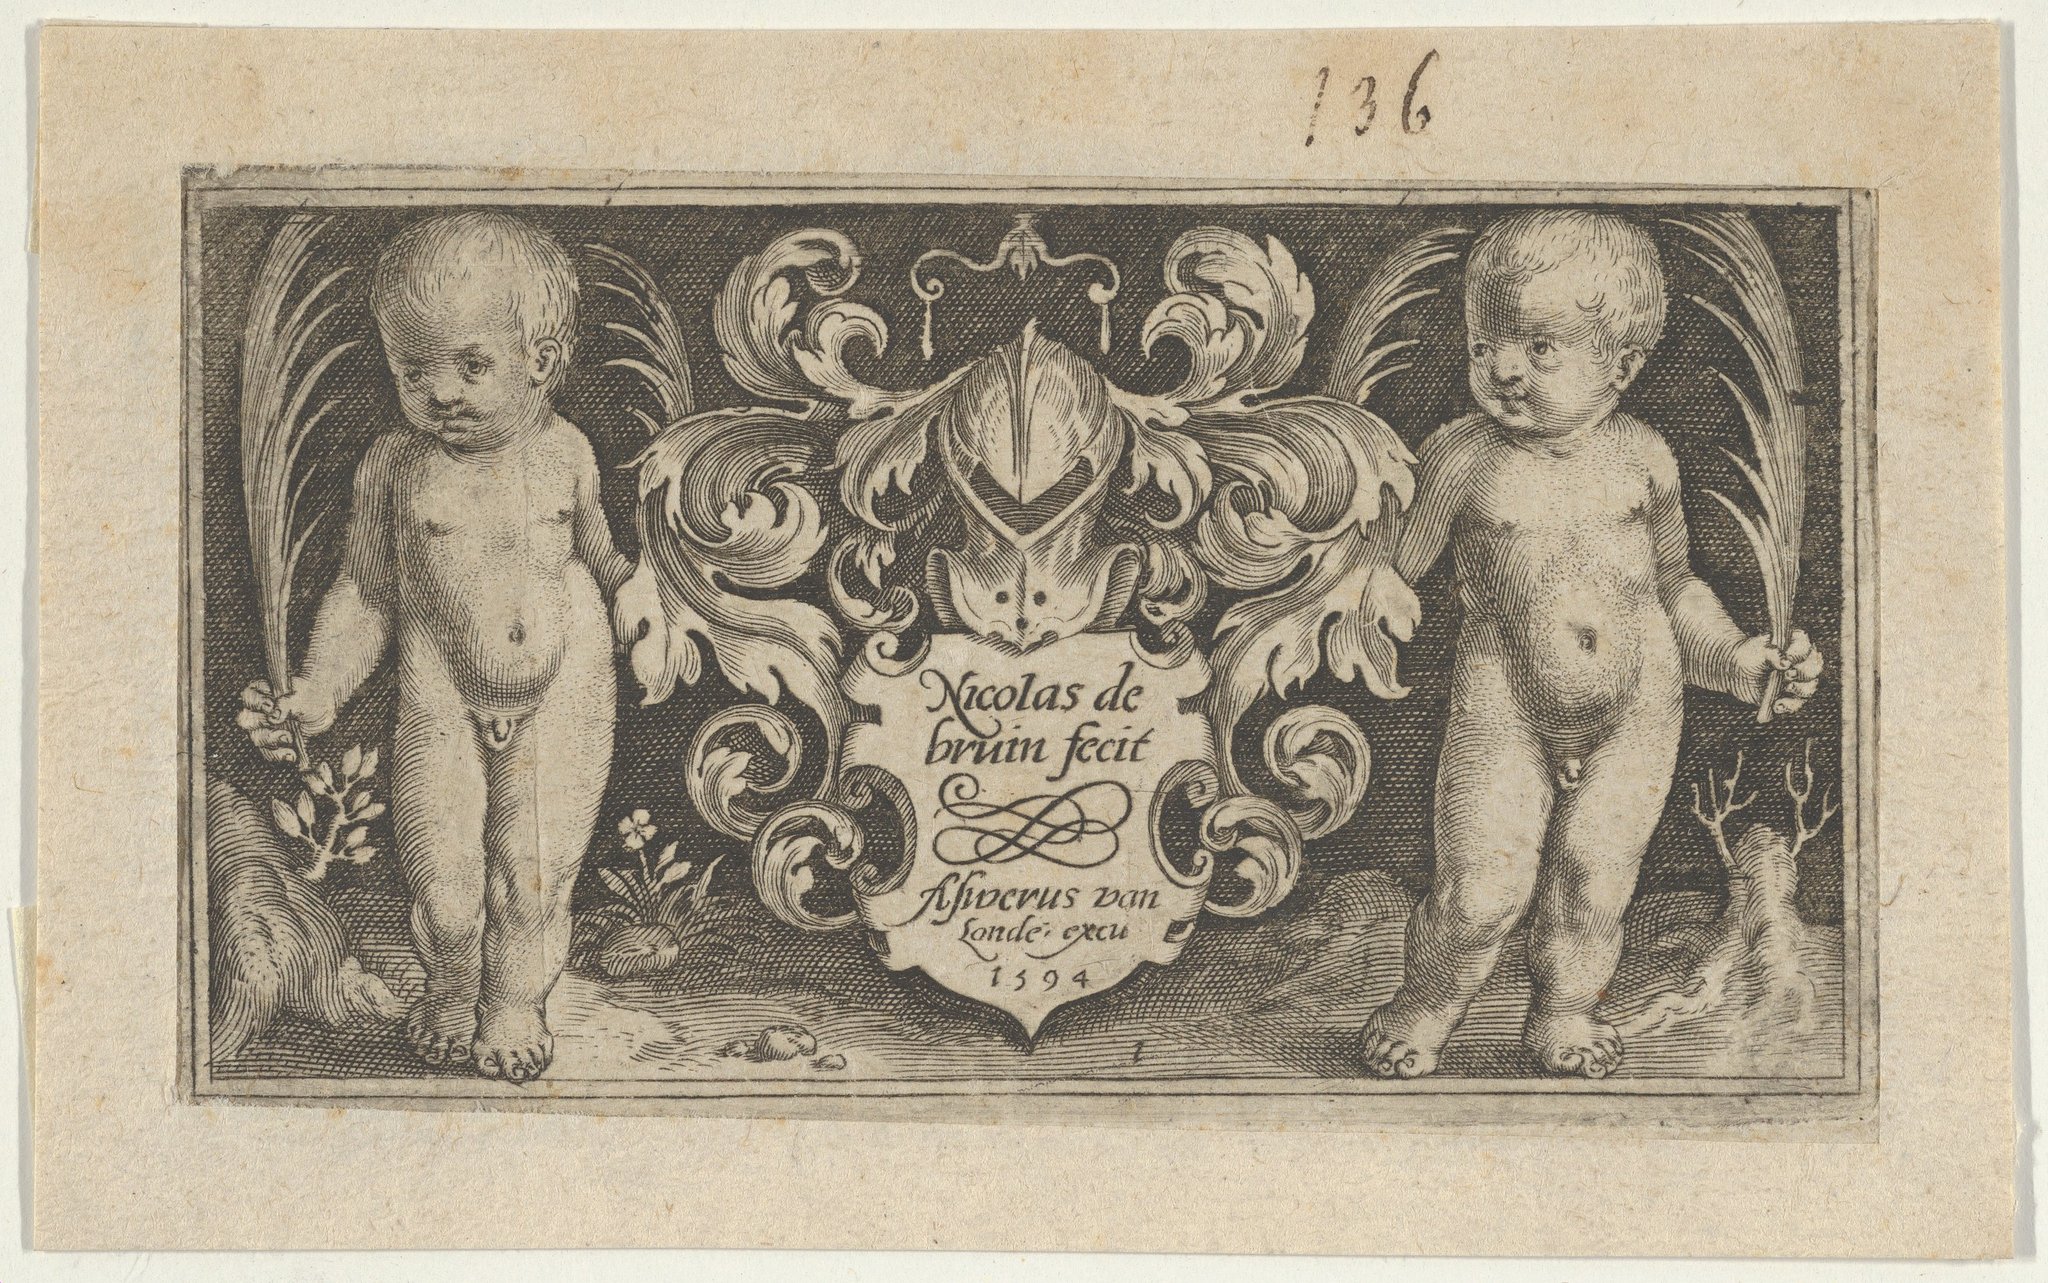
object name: print ornament architecture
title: Title Page, from Two Genii with Animals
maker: nicolaes de bruyn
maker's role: artist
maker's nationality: netherlandish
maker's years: 1571-1656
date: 1594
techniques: engraving